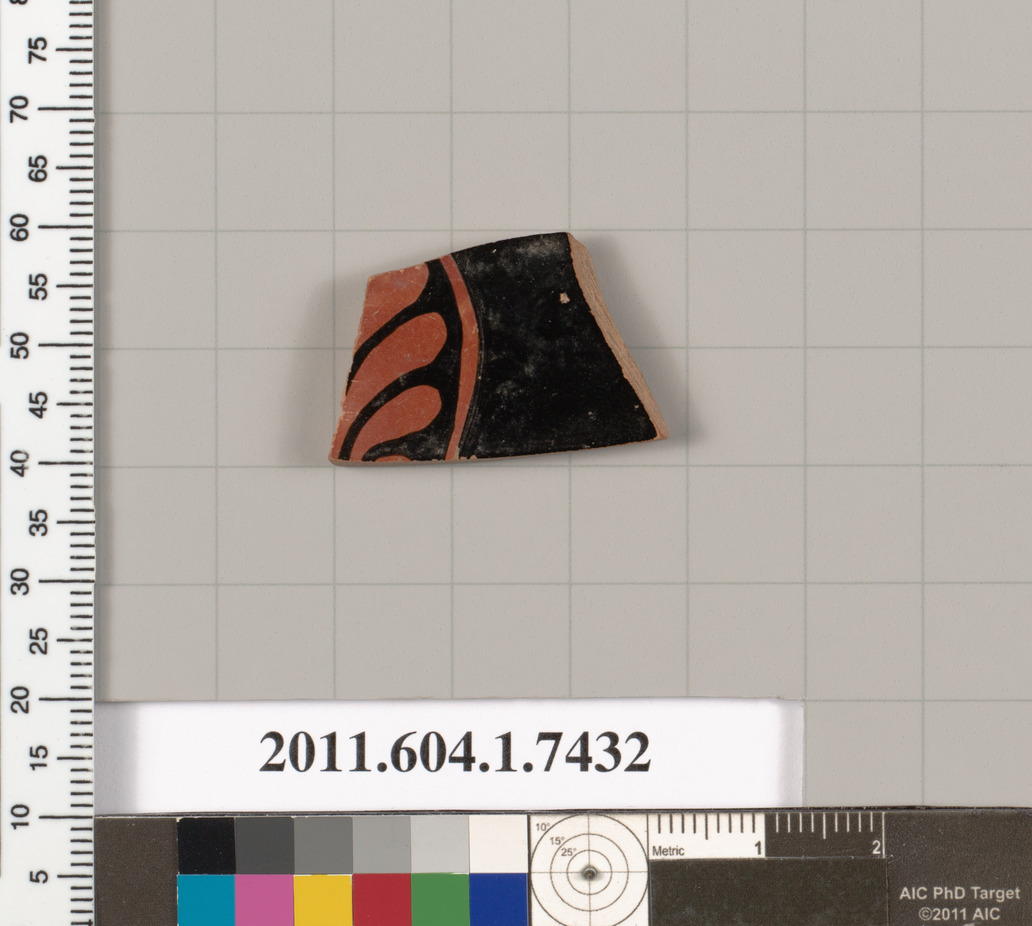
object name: kylix fragment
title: Terracotta fragment of a kylix (drinking cup)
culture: greek, attic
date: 490-470 BCE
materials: terracotta